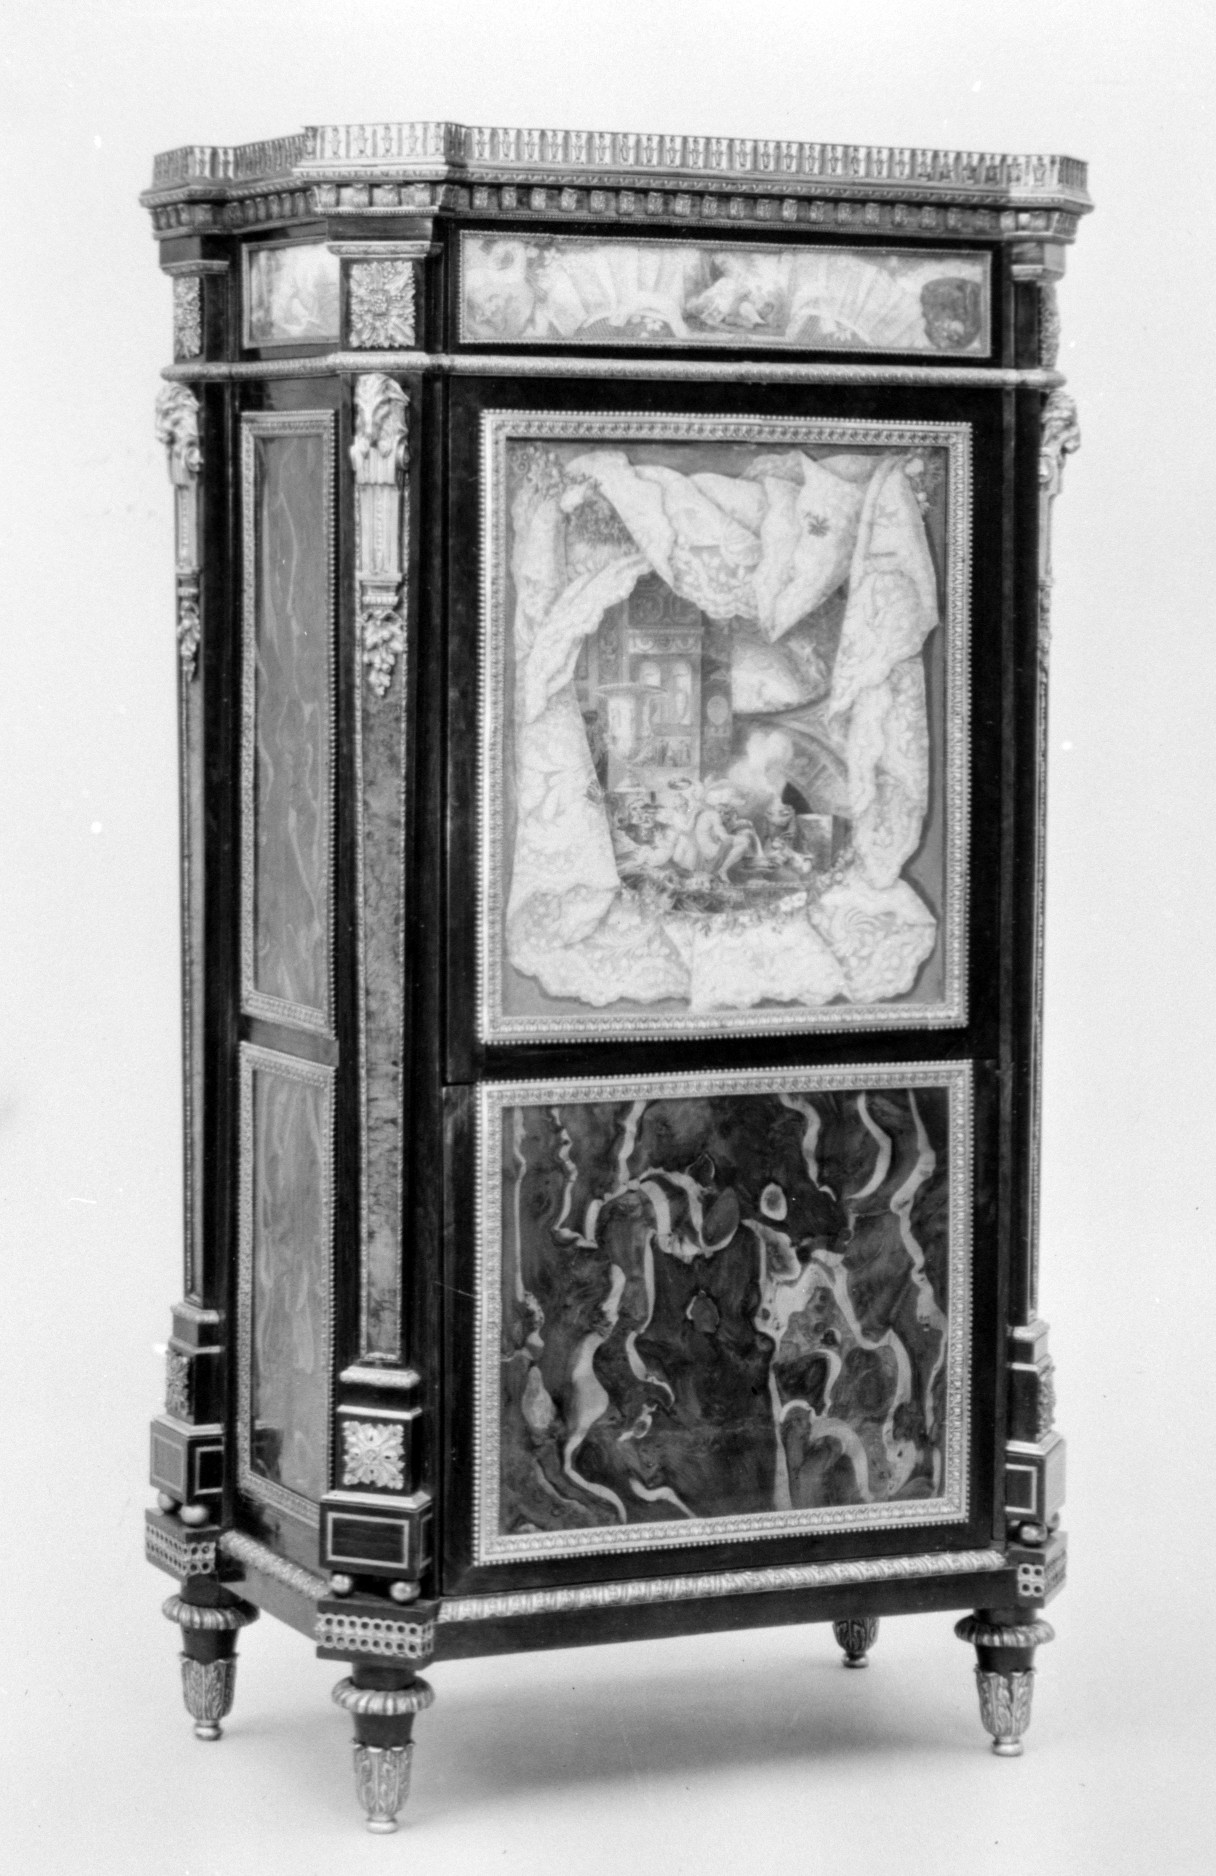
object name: secretary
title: Upright secretary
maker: philippe pasquier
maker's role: artist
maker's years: 1683-1783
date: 1767-1800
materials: gilt bronze, marble, wood, paper, textile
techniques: stain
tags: furniture